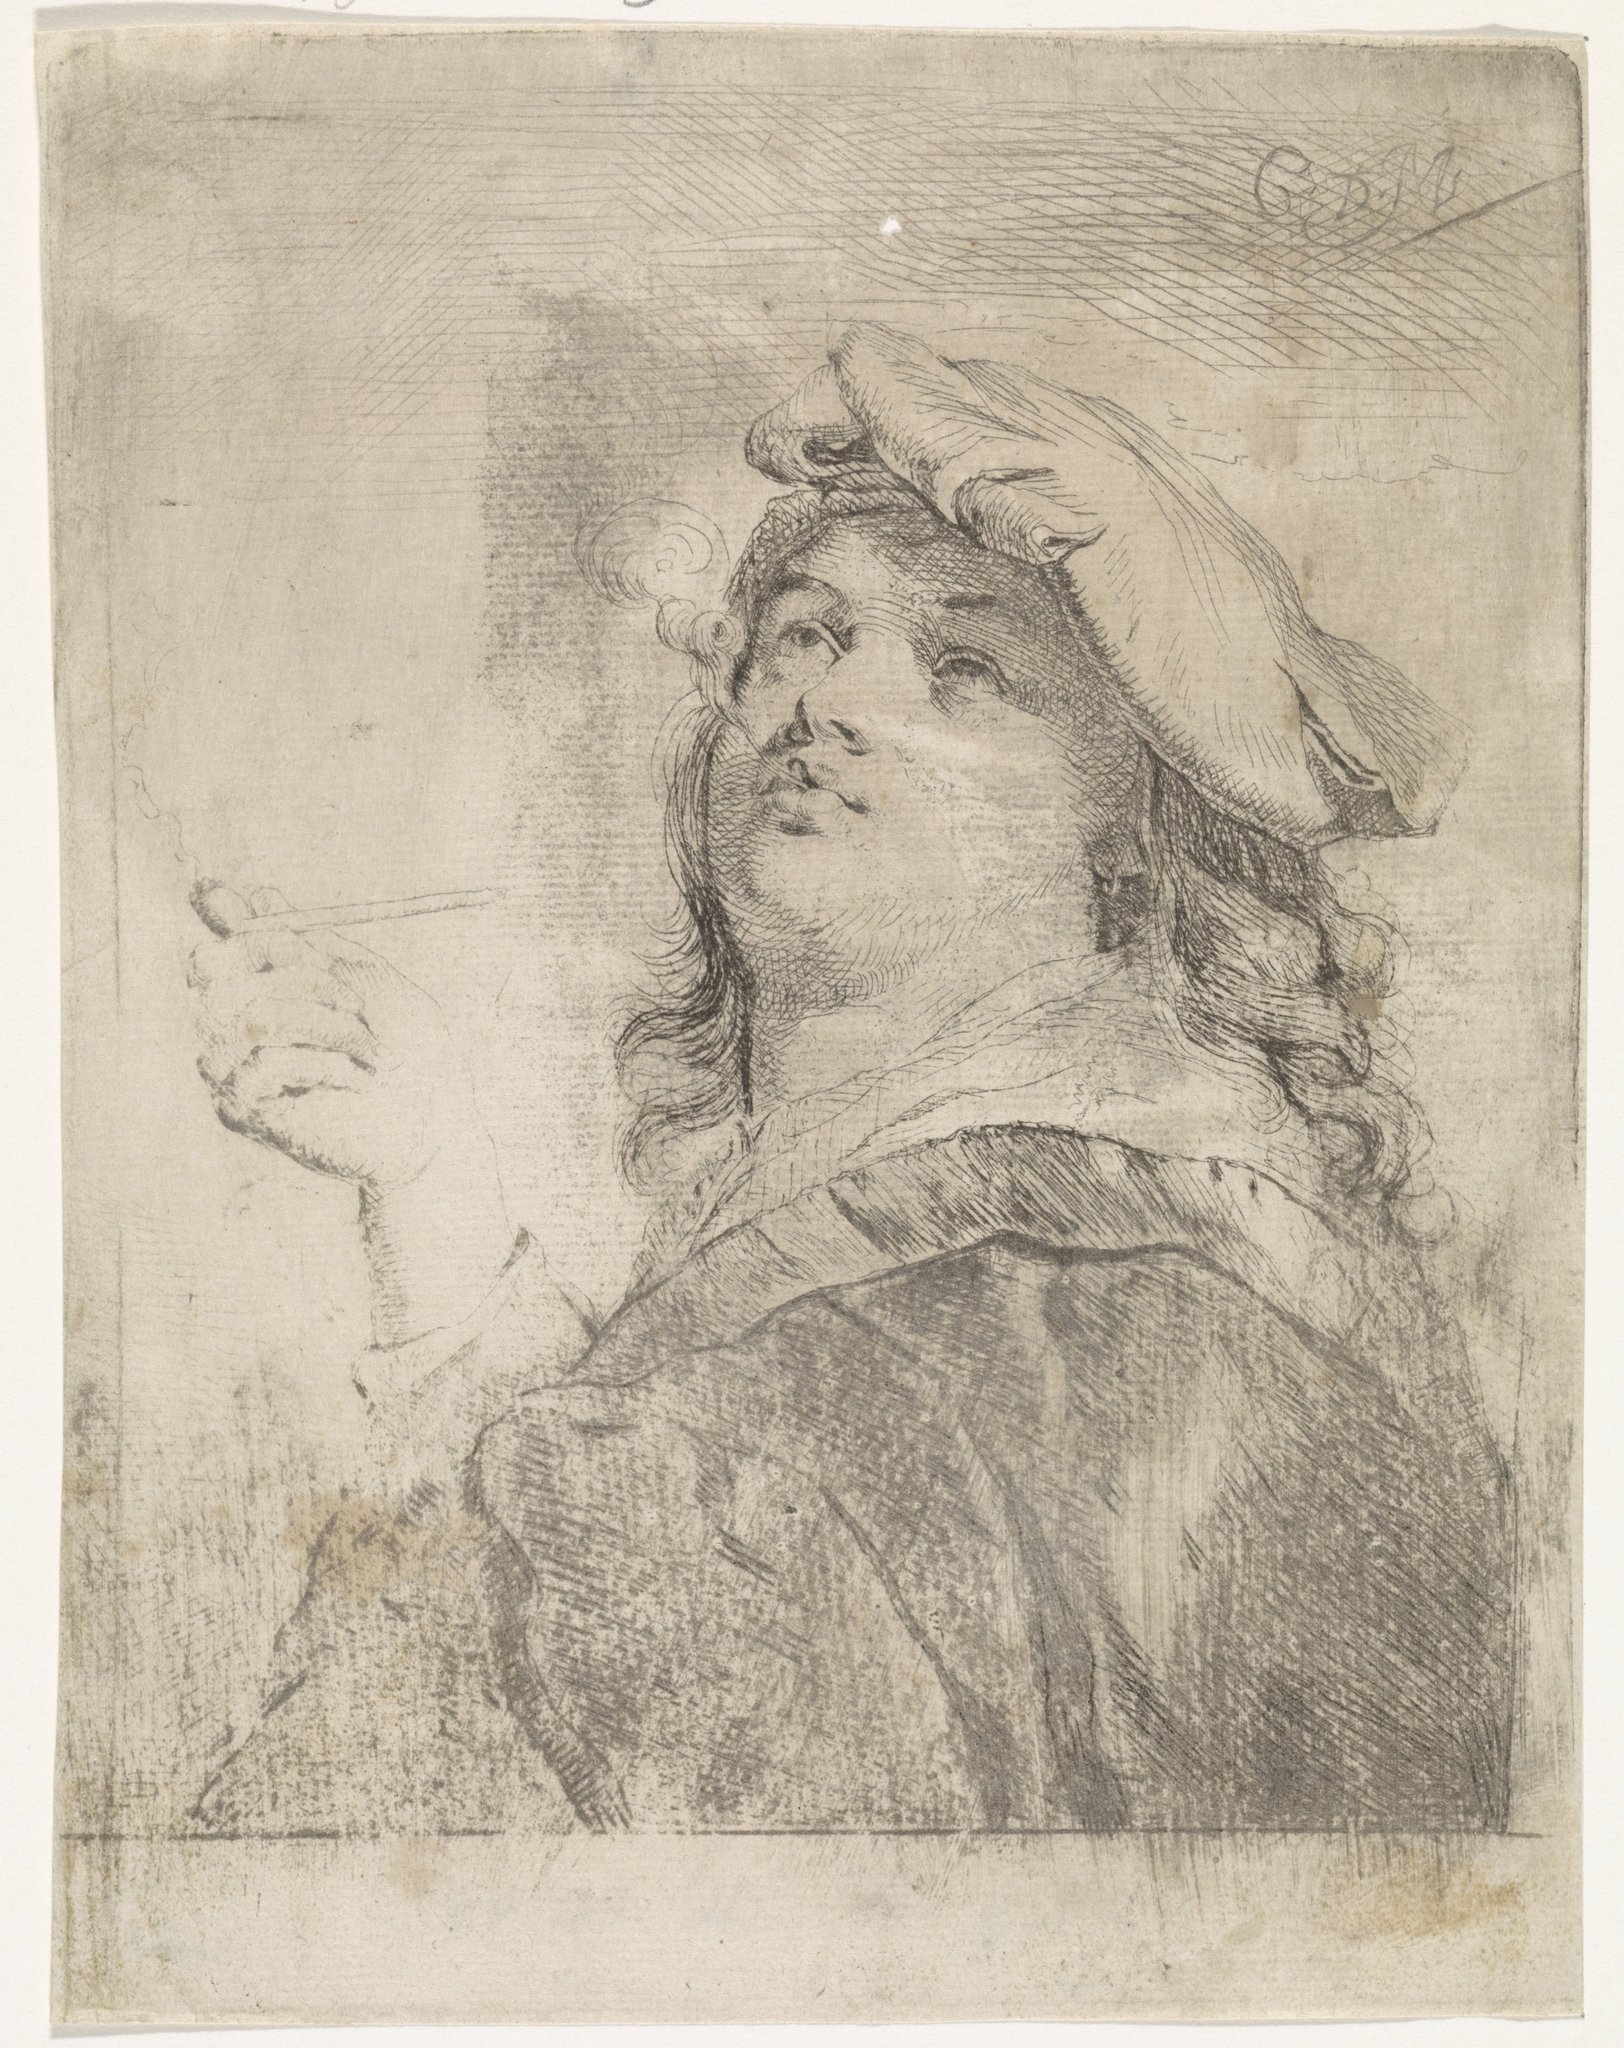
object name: print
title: Roker met een pijp in de hand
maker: carel de moor (ii)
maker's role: draughtsman, painter, print maker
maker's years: 1655-1738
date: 1665-1738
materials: paper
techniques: drypoint, etching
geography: netherlands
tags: head-gear: cap (+ men's clothes), pipe ~ tobacco (+ eating, drinking, smoking, chewing, etc. in secret, furtively)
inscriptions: collector's mark: Lugt 240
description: Een man met lange haren en een baret op het hoofd rookt een pijp.